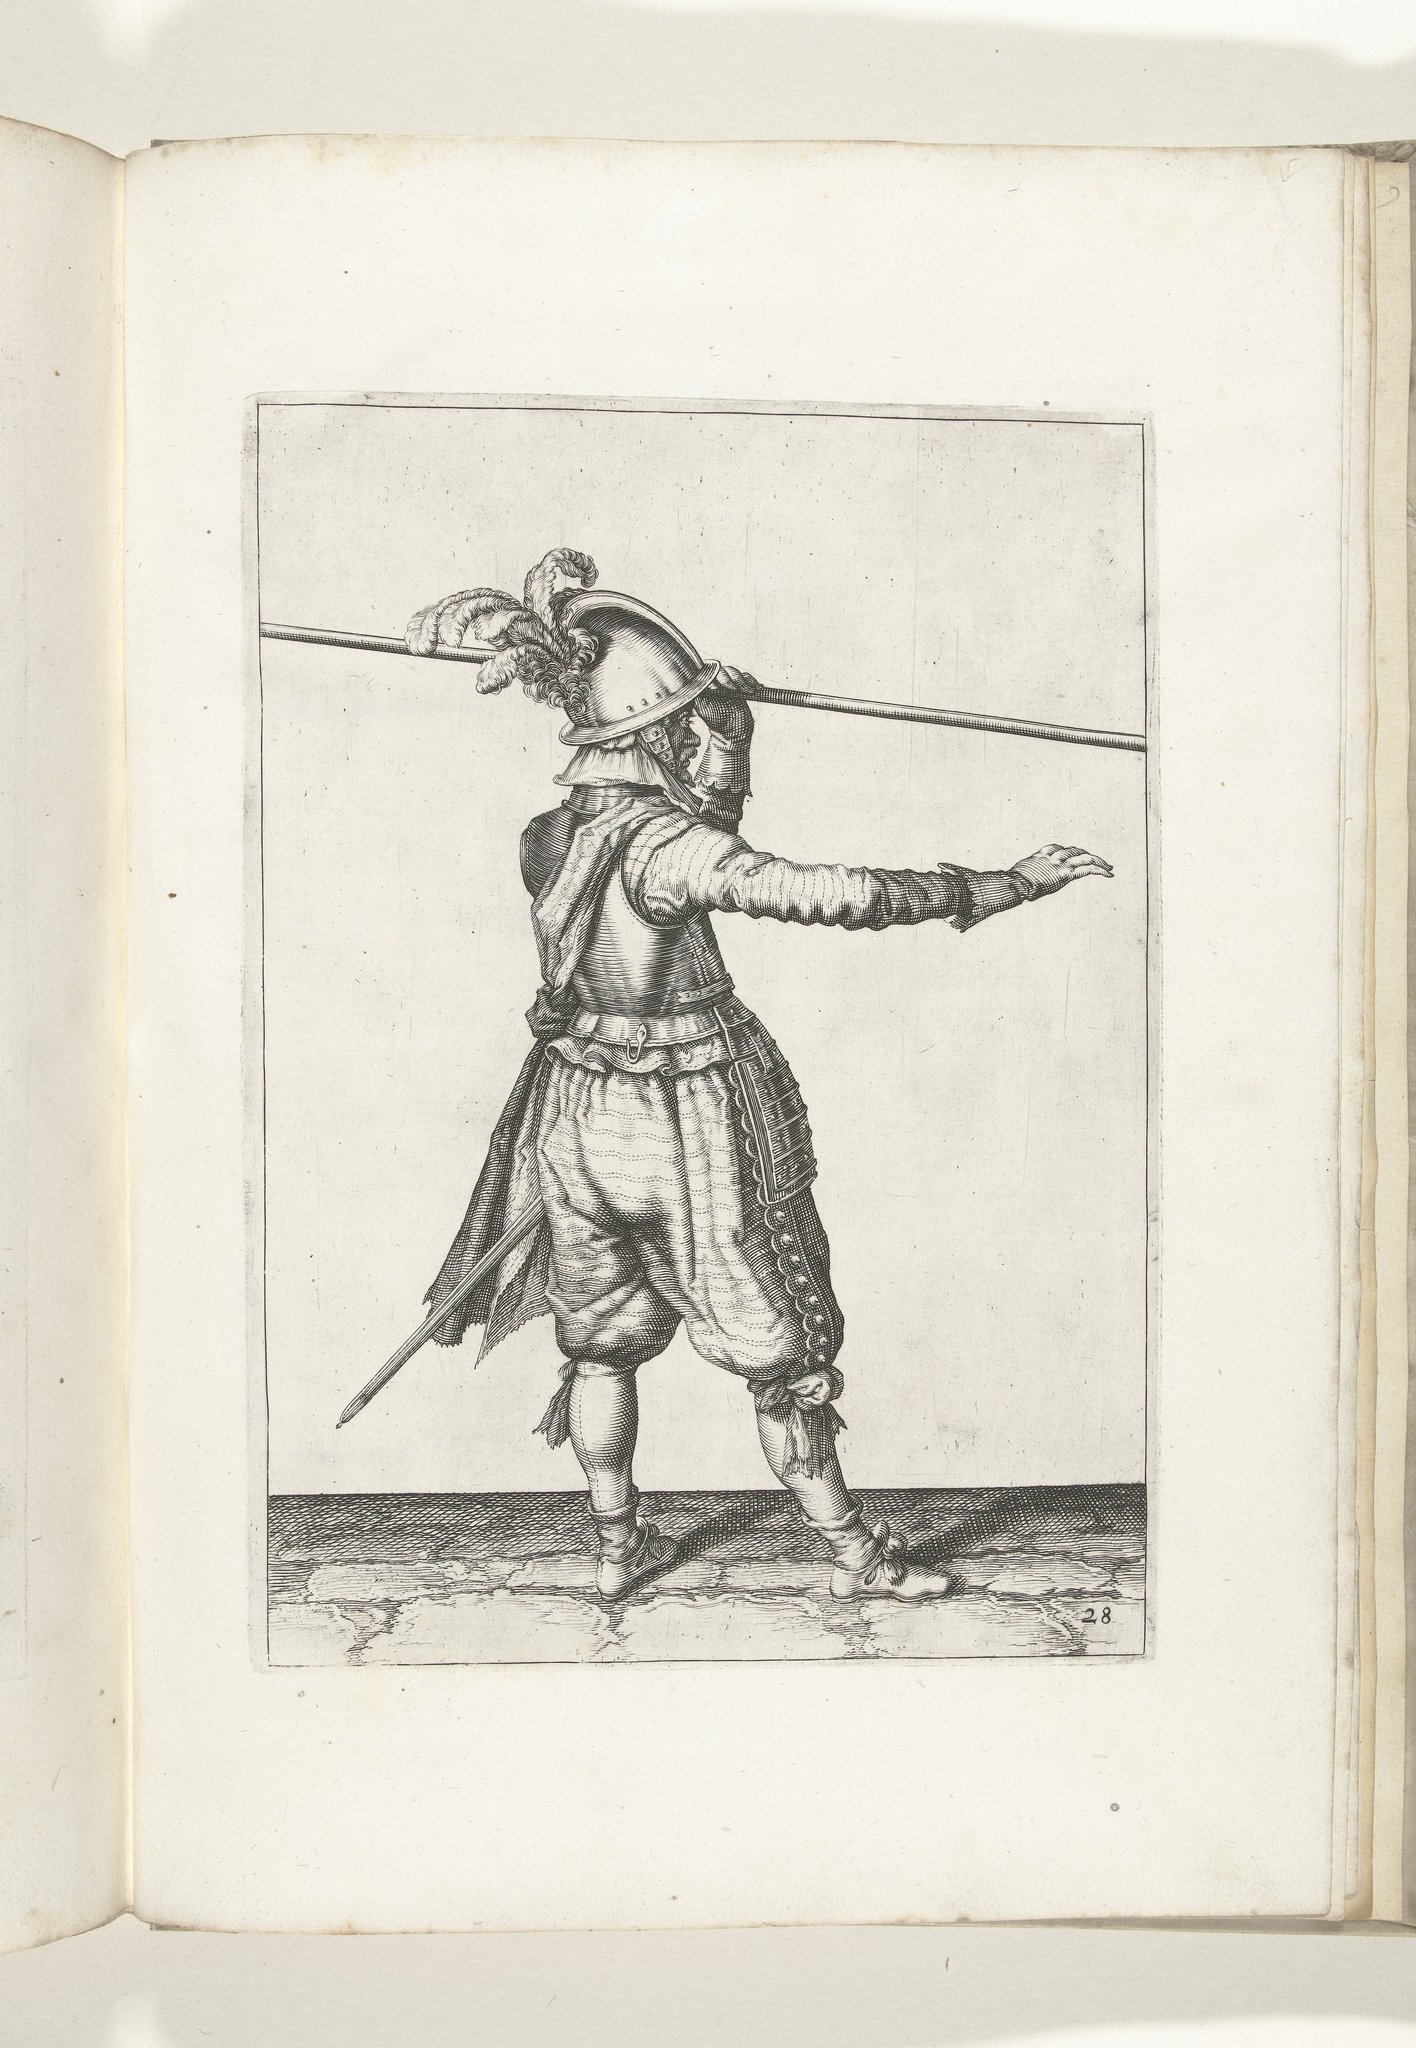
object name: print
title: Soldaat die zijn spies met zijn linkerhand boven zijn linkerschouder draagt, zijn rechterhand uitgestrekt naar voren (nr. 28), ca. 1600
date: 1597-1607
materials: paper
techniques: engraving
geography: northern netherlands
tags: maurice (prince of orange), handling of weapons ~ military training, weapons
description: Een soldaat, ten voeten uit, naar rechts, die een spies (lans) met zijn linkerhand boven zijn linkerschouder draagt, zijn rechterhand uitgestrekt naar voren (nr. 28), ca. 1600. Plaat 28 in de instructies voor het hanteren van de spies: Corte onderwysinghe op de figuerliicke afbeeldinghe, belanghende t'recht ghebruyck, van al t'ghene een Soldaet int handelen vande Spies noodich is. Onderdeel van de illustraties in: J. de Gheyn, Wapenhandelinghe van Roers Musquetten ende spiessen, 's-Gravenhage, 1607. Krijgswezen rond 1600.